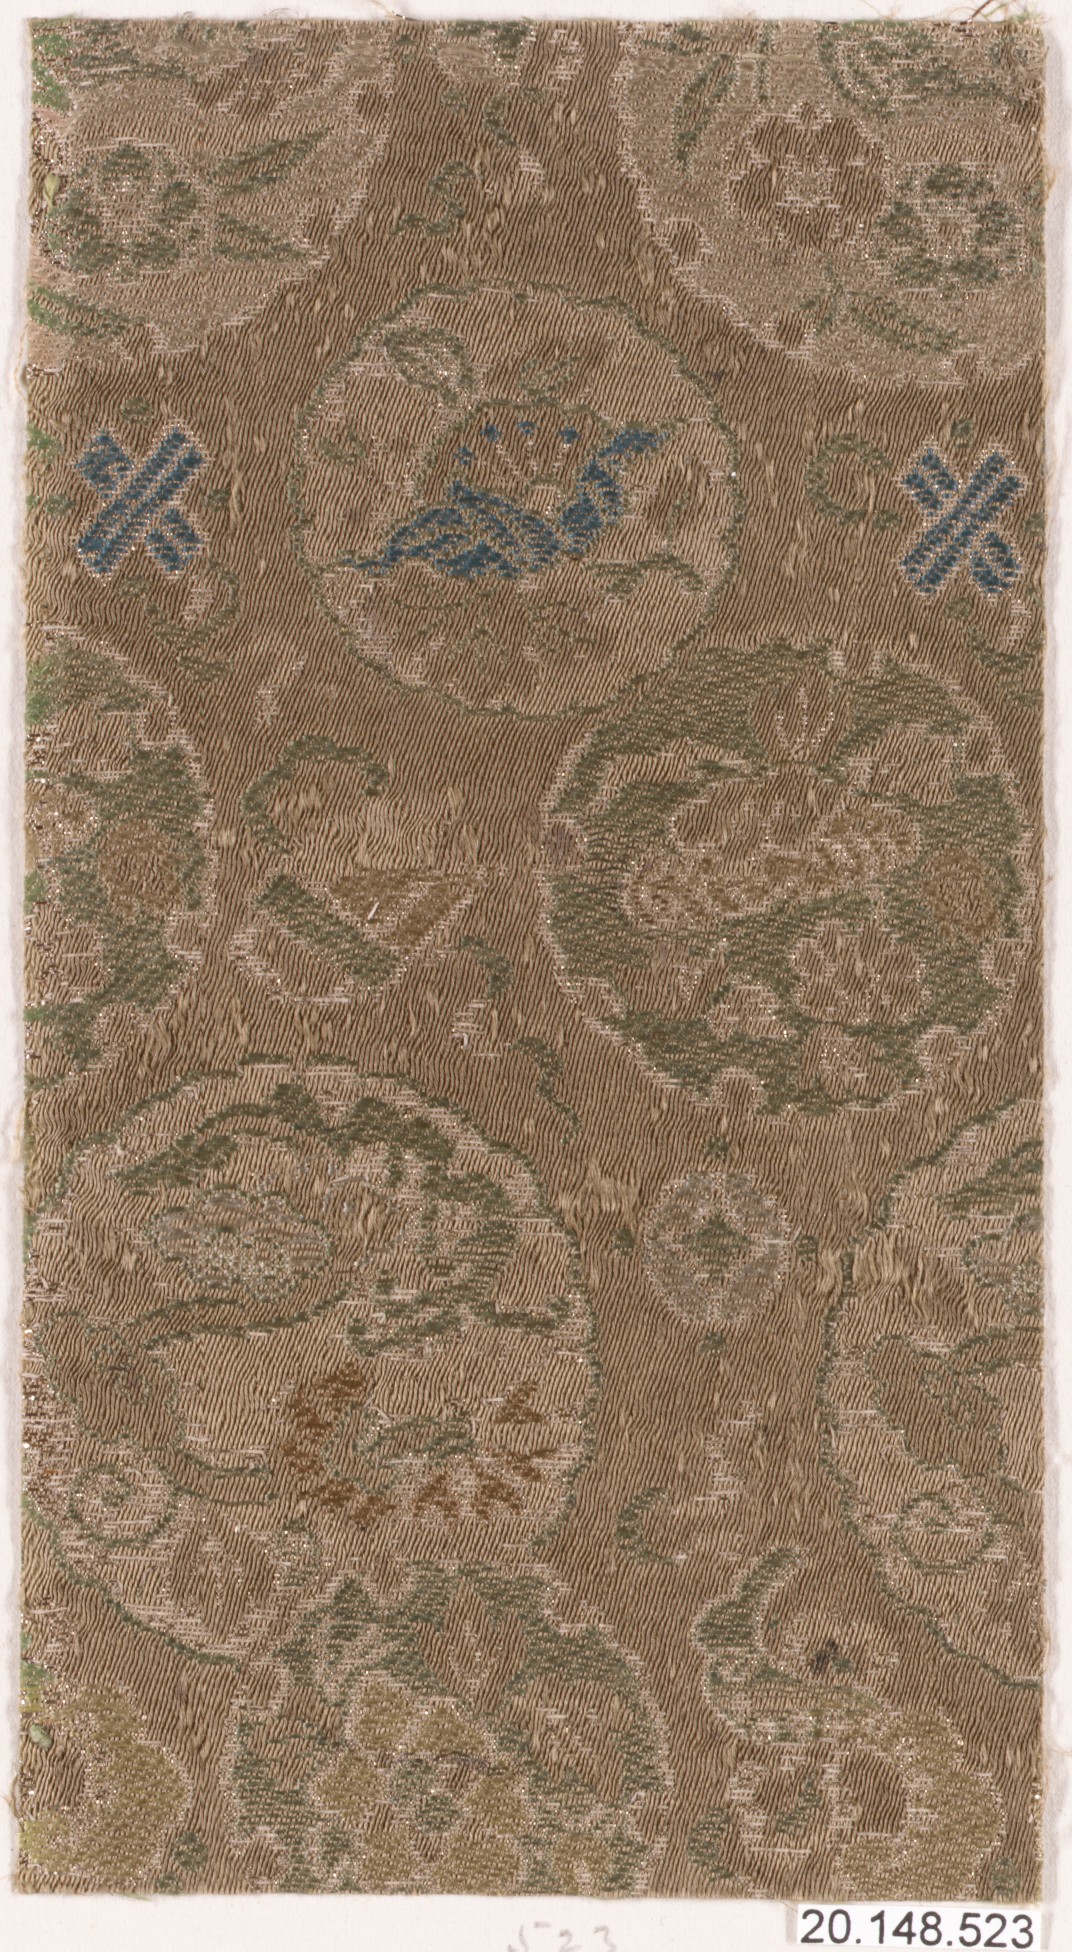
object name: piece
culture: japanese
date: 1701-1800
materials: silk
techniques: compound weave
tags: flowers,leaves